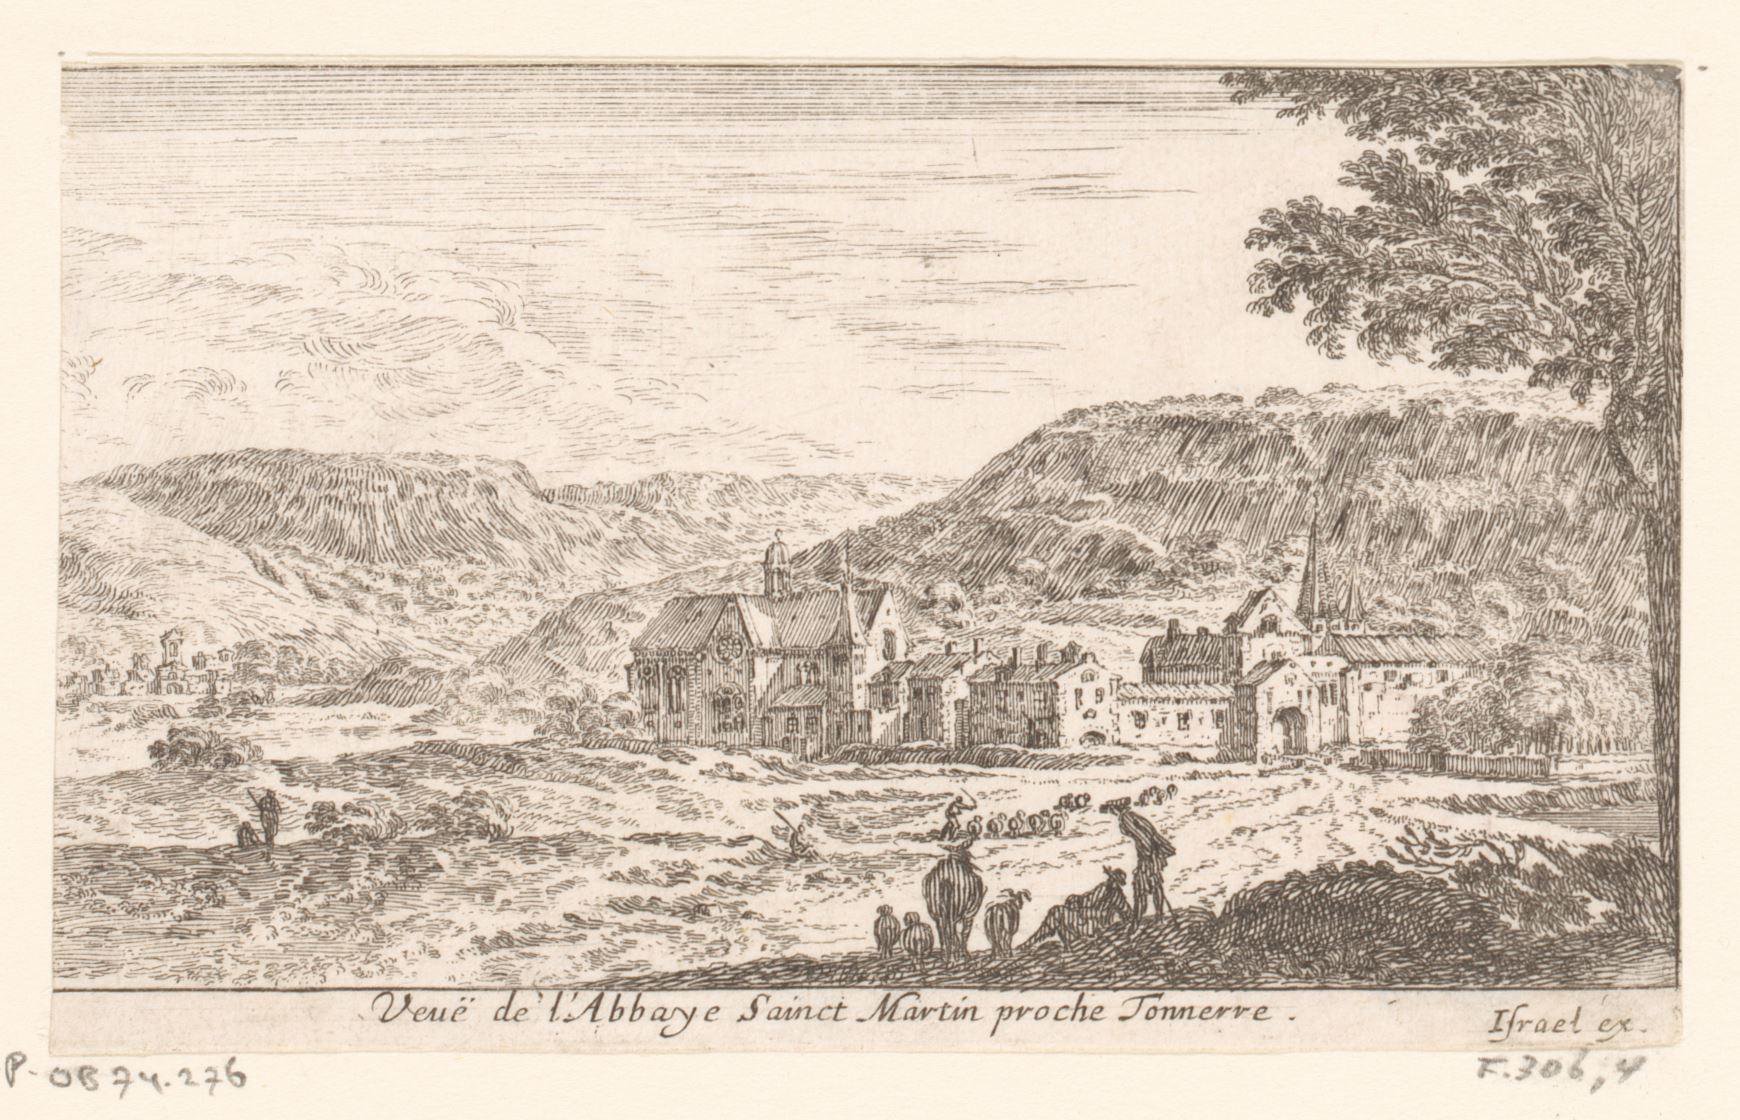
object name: print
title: Gezicht op abdij in de buurt van Tonnerre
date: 1631-1661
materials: paper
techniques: etching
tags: city-view, and landscape with man-made constructions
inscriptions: collector's mark: Lugt 240